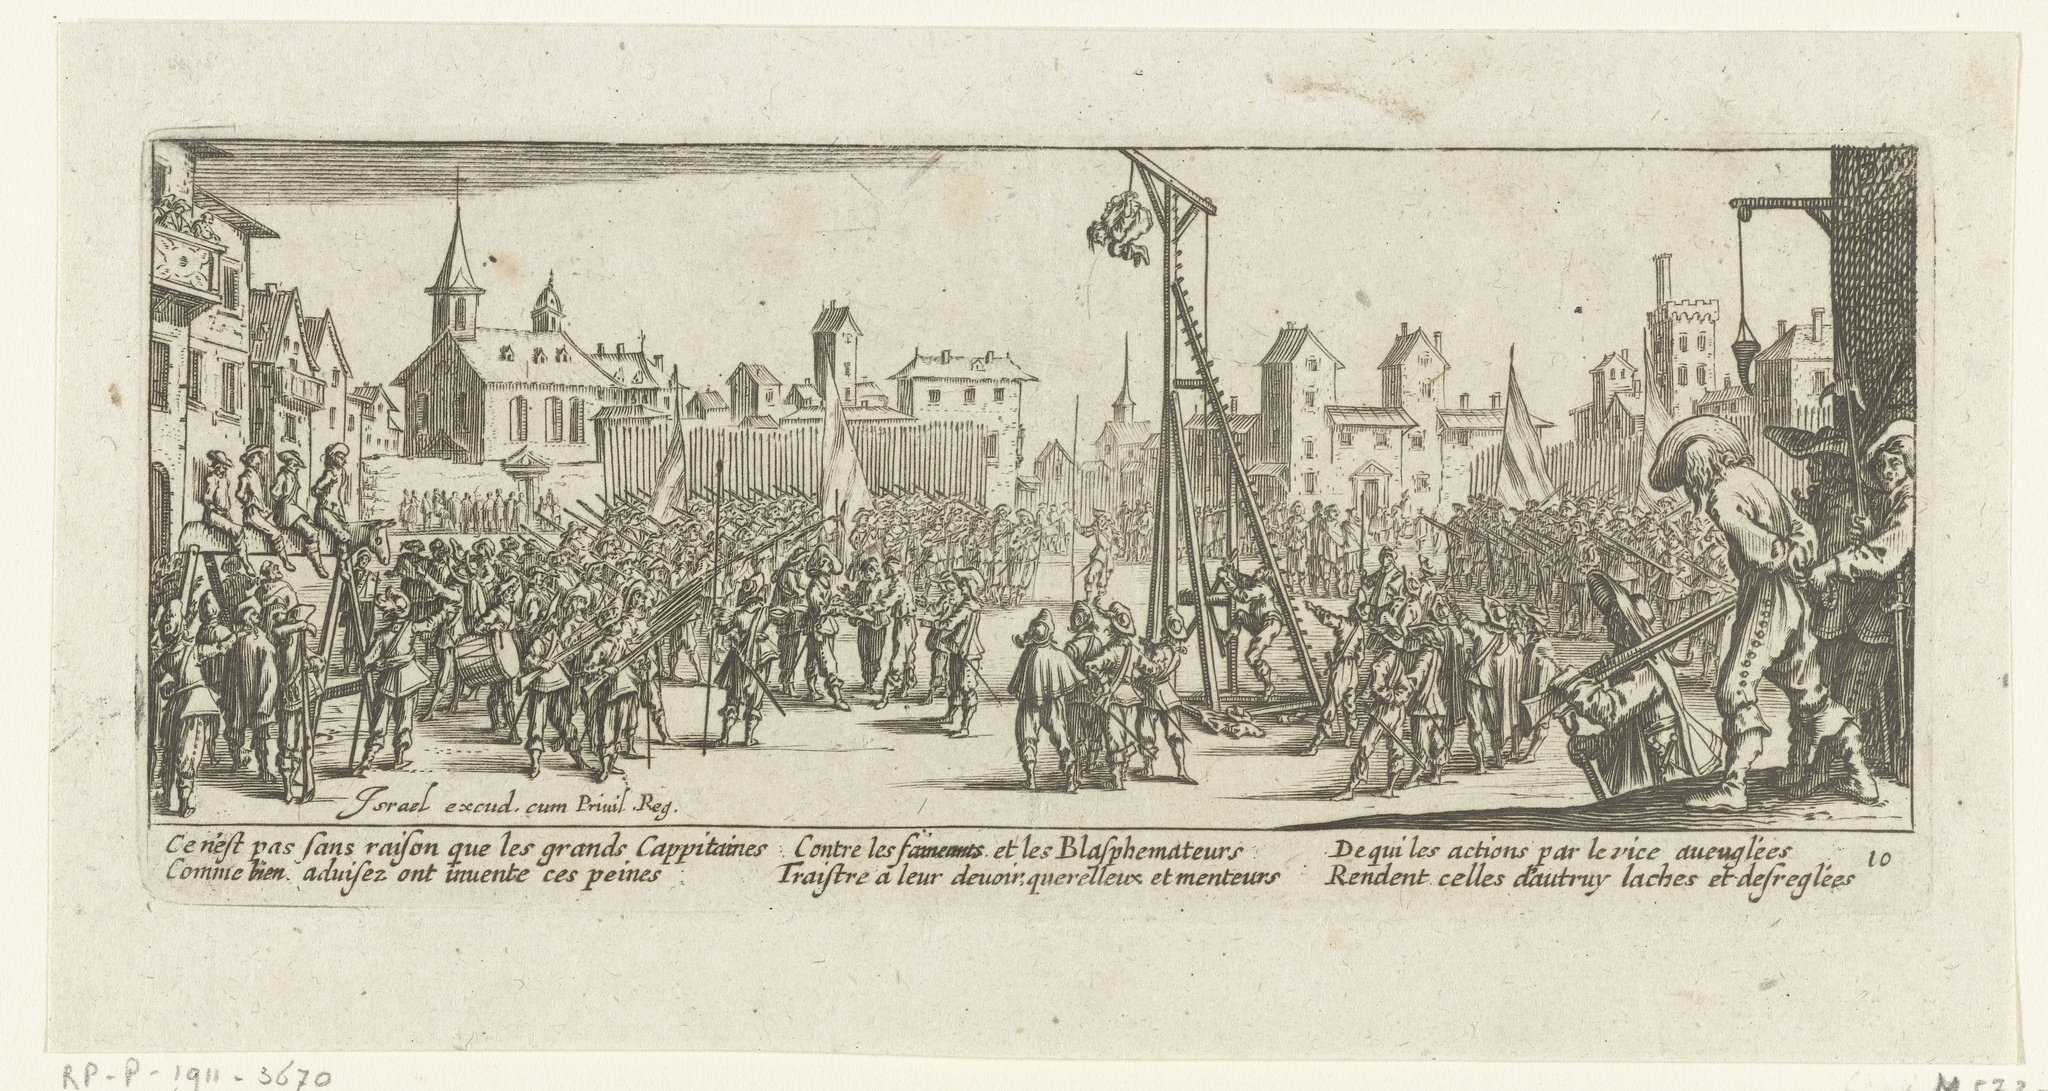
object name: print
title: De droeve ellendigheden van de Oorloogh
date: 1677-1690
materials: paper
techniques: etching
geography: netherlands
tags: physical punishment ~ military service, village square, place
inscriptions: collector's mark: Lugt 2228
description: Op een stadsplein zijn vele soldaten verzameld rond een wipgalg. Een man hangt bovenin de galg aan een touw. Rechts op de voorgrond een soldaat met de handen op de rug gebonden. Links op de achtergrond vier gevangenen op een houten paard. Onder de voorstelling een zesregelig Frans vers. Deze prent is onderdeel van een serie van 17 (18 incl. titelprent) prenten met voorstellingen van diverse soorten ellende die oorlogvoering met zich meebrengt.